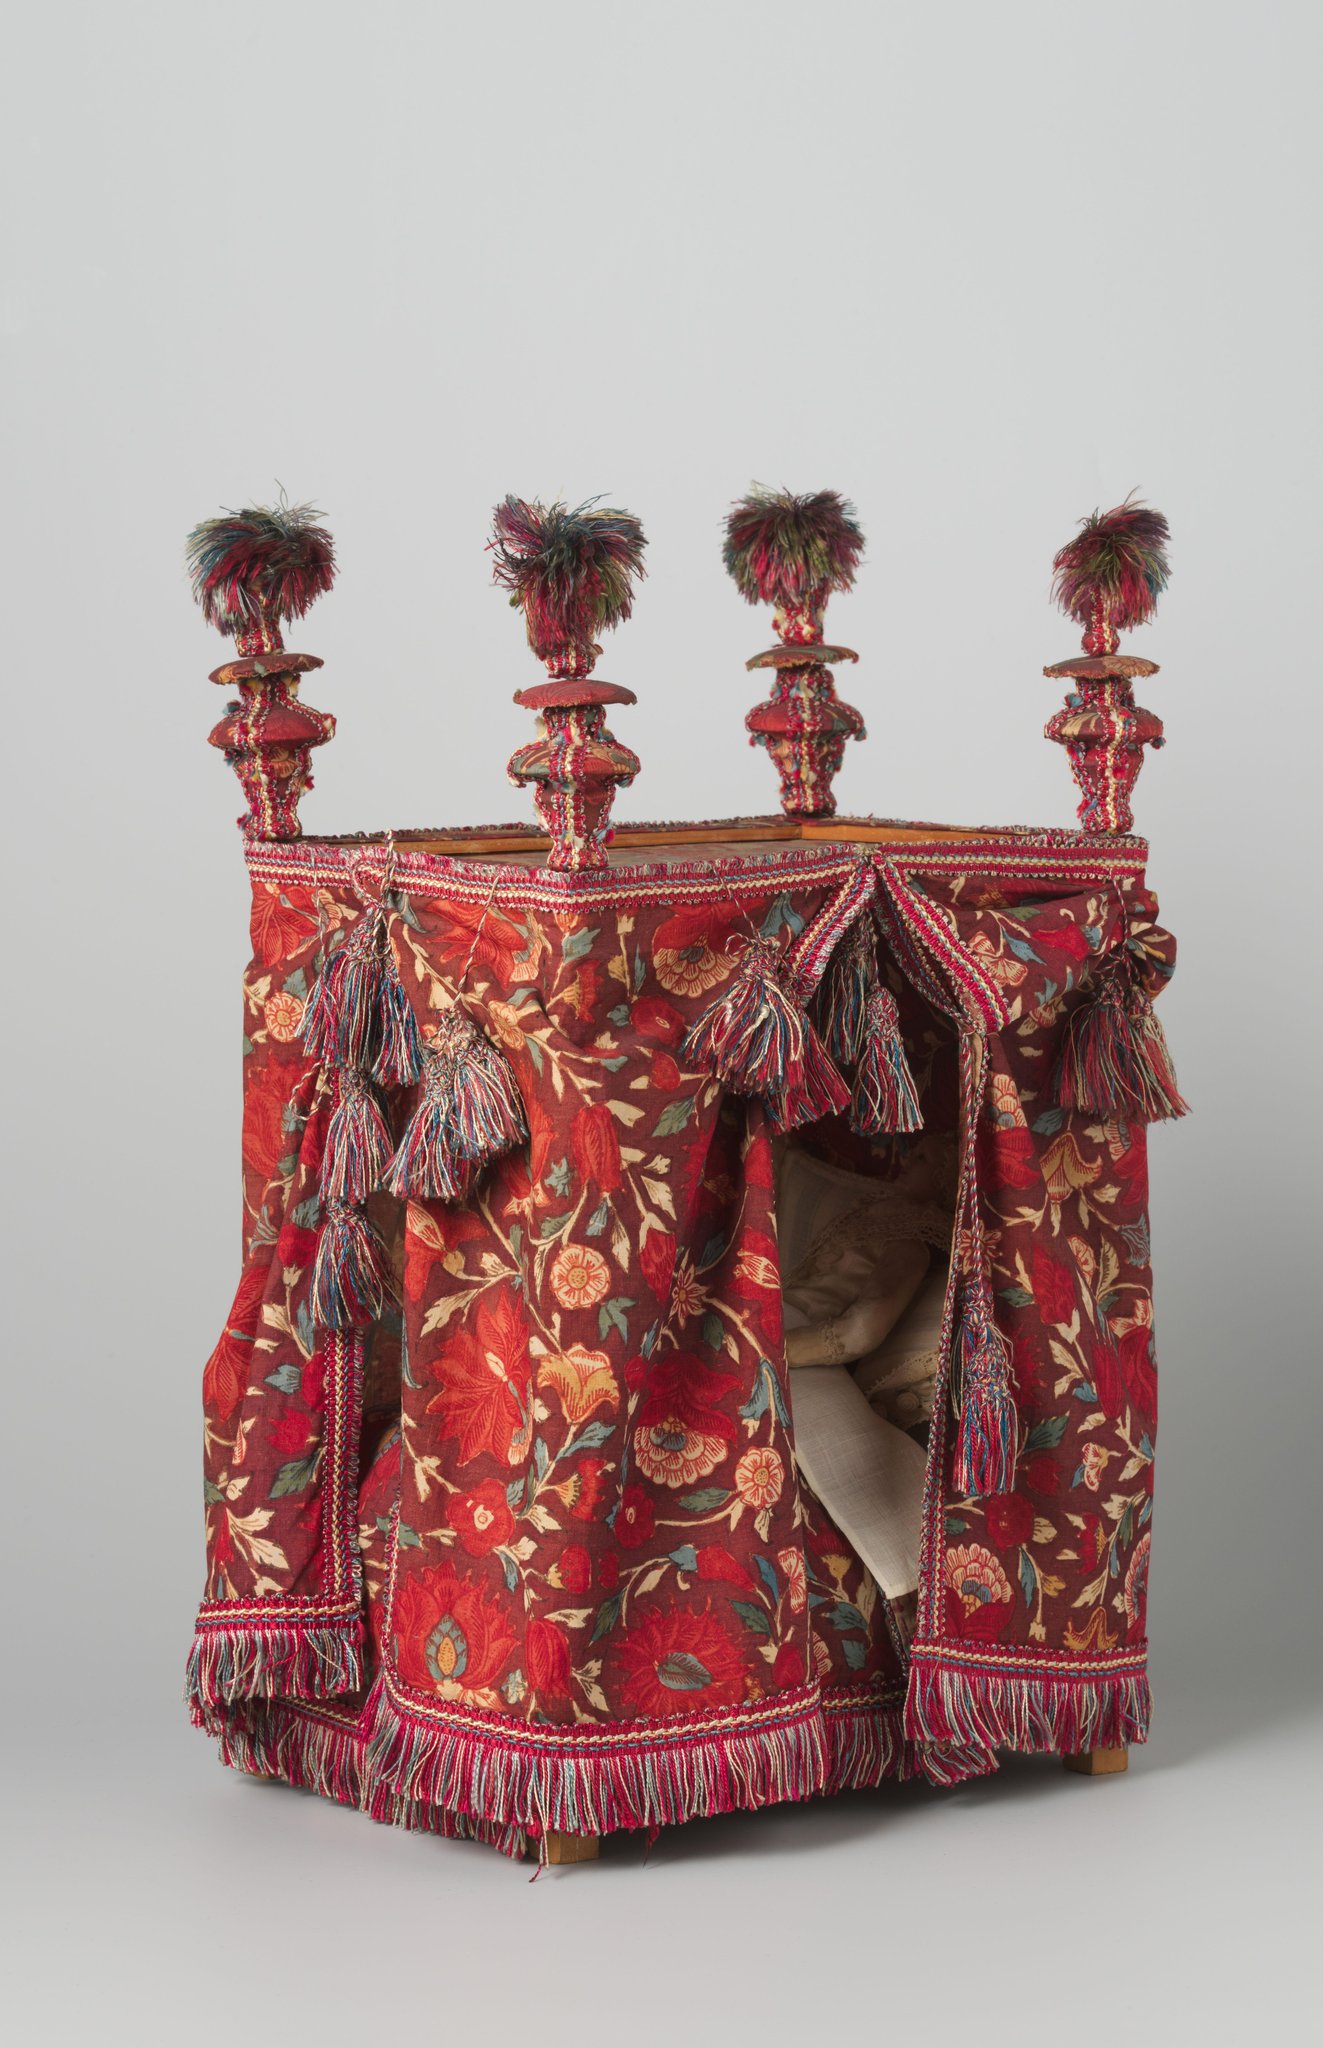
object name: canopy bed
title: Hemelbed, vervaardigd van without met gordijnen van sits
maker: Anonymous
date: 1676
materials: cotton, metal, silk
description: Hemelbed, vervaardigd van without, opgetuigd met gordijnen van sits beschilderd met een golvend bloemrankenpatroon op een houten geraamte, bestaat uit vier stijlen, van onderen vierkant van doorsnede, boven de matras rond, waartussen schotten van de matrasbak zijn bevestigd. Het achterschot iets verhoogd. De bodem van de matrasbak bestaat uit twee houten dwarsliggers. Tussen de twee achterstijlen is als achterwand een stuk sits gespannen, dat om de stijlen heen naar achteren is gevouwen. Op de stijlen rust een rechthoekig raamwerk van vier latten, waaromheen als hemelbedekking sits is gespannen, eveneens van binnenuit geheel om de latten heen naar boven en terug. Door het raamwerk en de stof zijn gaatjes geboord, drie aan elke zijde waardoorheen drie stel koorden met kwasten zijn gestoken, die de gordijnen ophouden. Op de vier hoeken zijn op ijzeren pinnen vier vaasvormige hoekversieringen geplaatst, bestaande uit gedraaide houten klossen en bolle schijven, beplakt met sits en een in vier verticale richels aangebrachte smalle galon, bovenop afgesloten door een naar beneden ombuigende, veelkleurige kwast. Het bed is behangen met vier gordijnen van sits, rondom afgezet met galon, van onderen met franje in kleur passend bij de sits. Twee gordijnen zijn iets breder dan de andere twee. Zij zijn strak vastgenaaid aan het hemelraamwerk, en aan zijkanten en voeteneinde schuin opgenomen door de koorden en kwasten. De gordijnen zijn nu zo gemonteerd (deze toestand is op alle oude foto's zo zichtbaar) dat zij lopen vanaf het midden van een zijde naar het midden van de volgende zijde en zodoende de hoekstijl bedekken. Aan voeten en hoofdeinde lopen de gordijnen iets over elkaar door. Bovendien is vanaf het midden van de zijwand, om het voeteneinde heen tot het midden van de andere zijwand een val aangebracht van sits, aan drie kanten afgezet met galon, aan de onderkant teruggeslagen en door de koorden en kwasten opgenomen middenachter en op de twee hoeken ter hoogte van de achterstijlen.